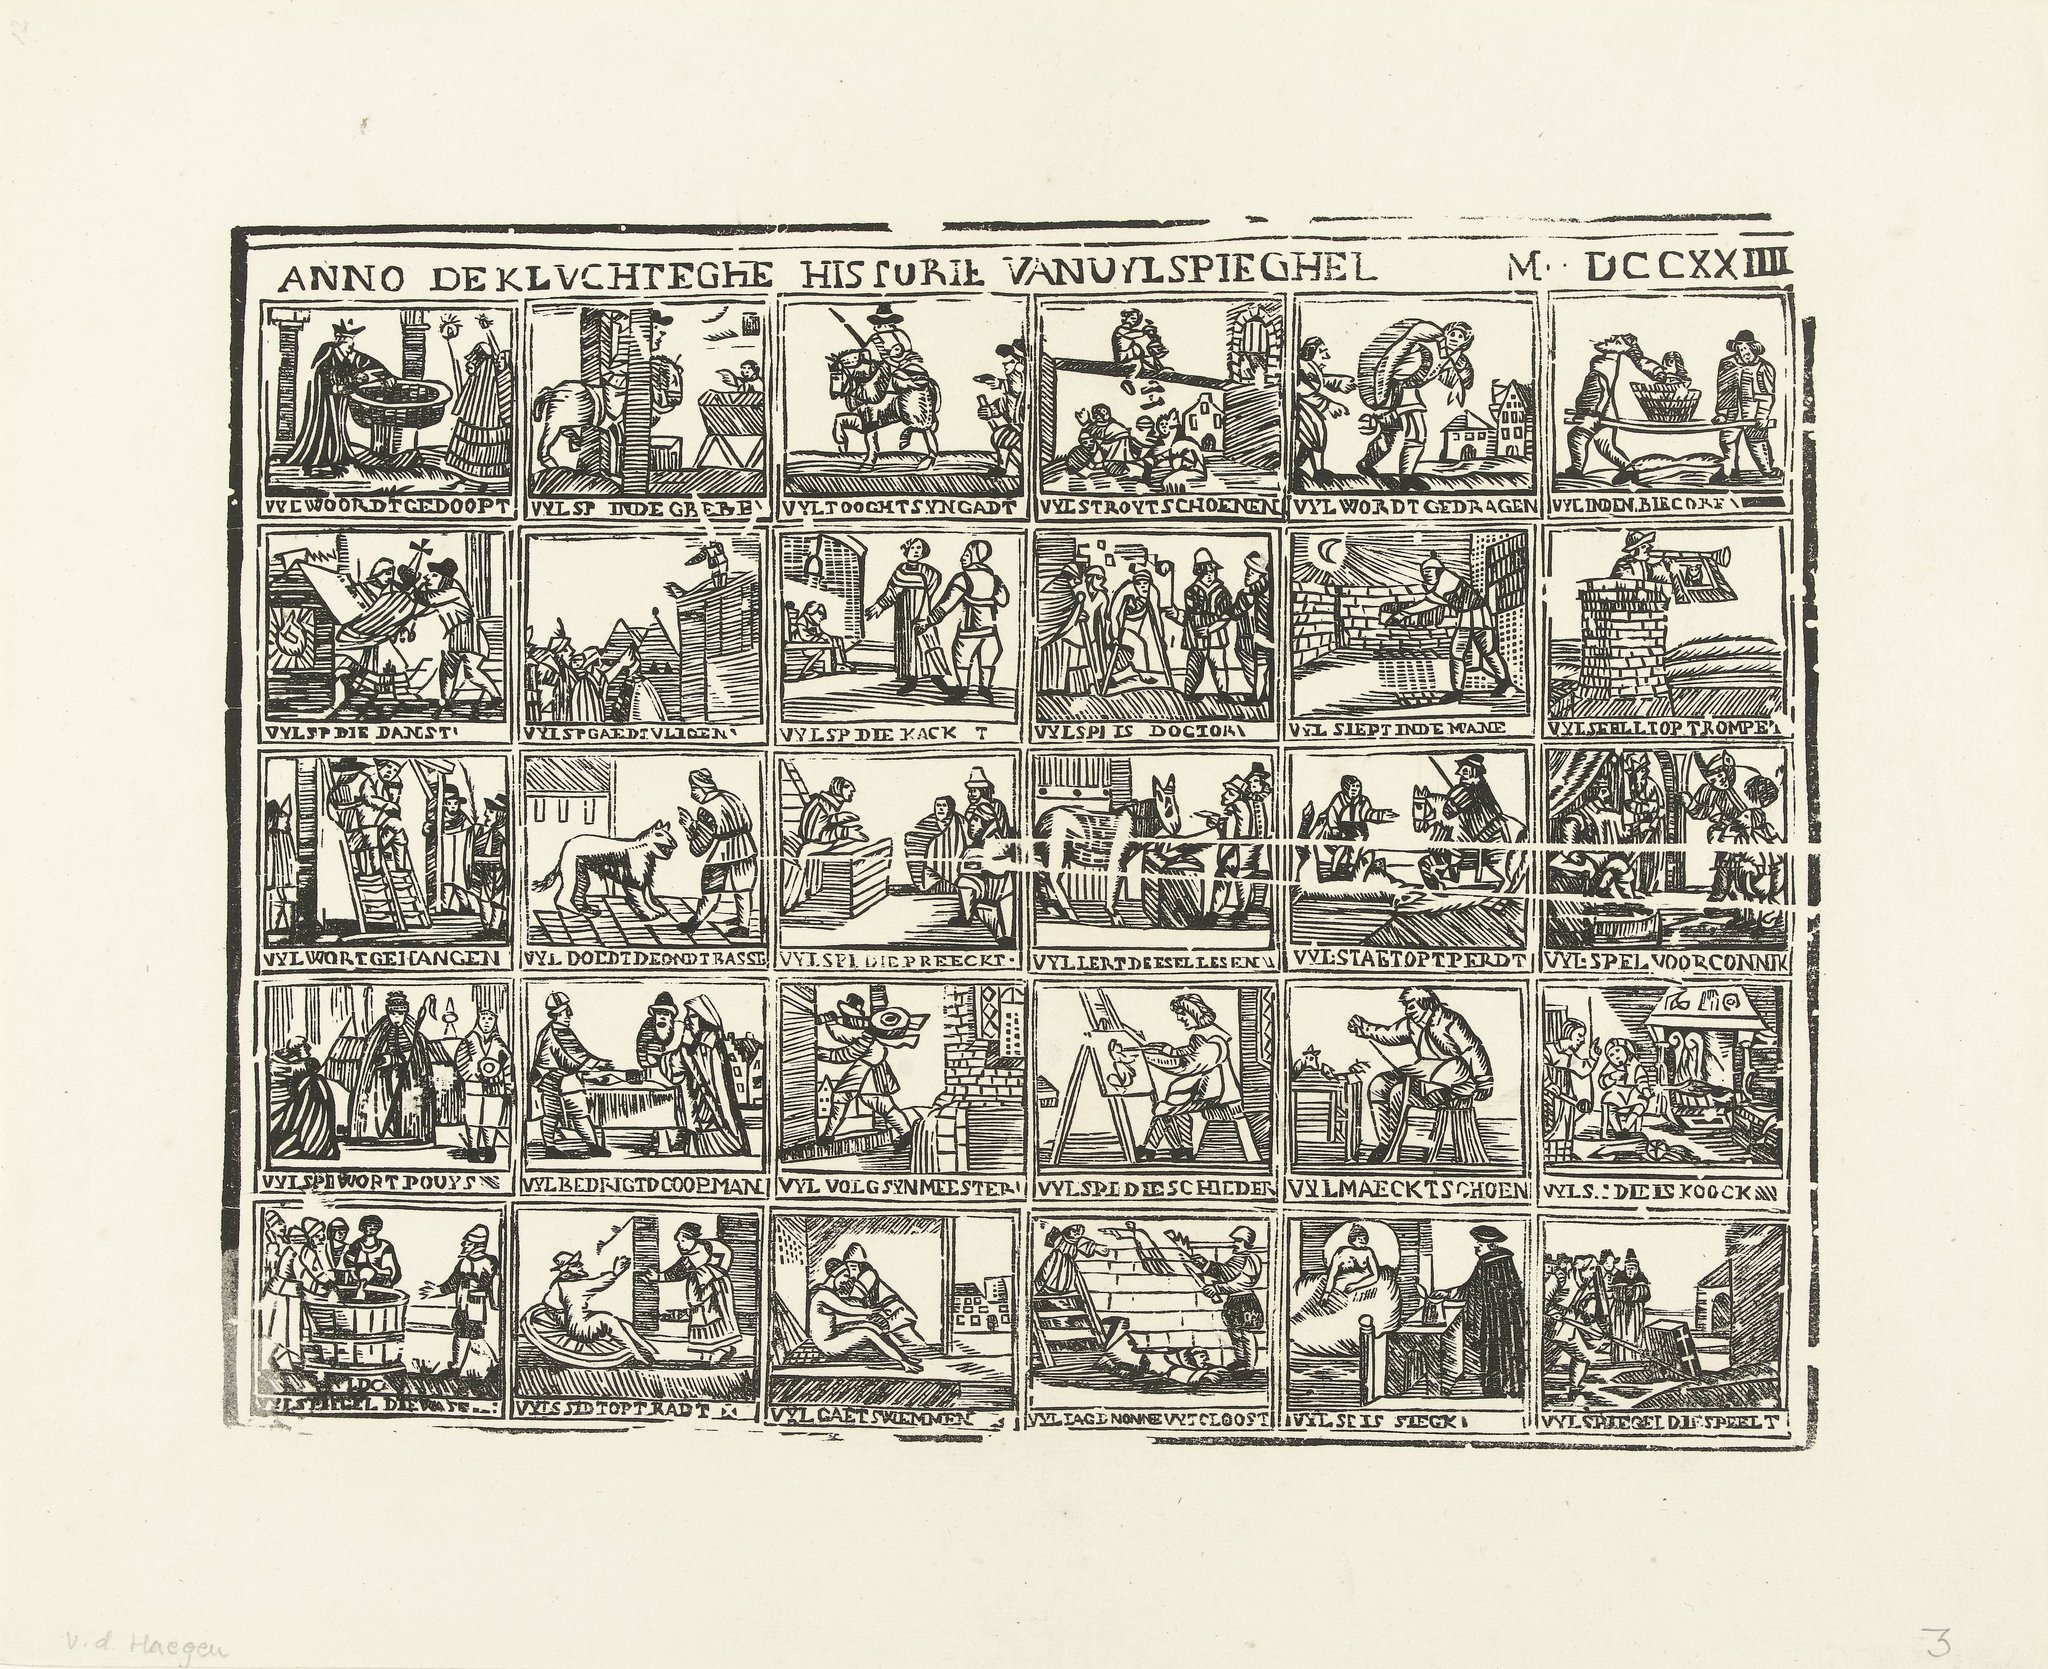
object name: popular print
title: De Klvchteghe Historie van Uylspieghel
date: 1724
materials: paper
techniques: woodcut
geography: ghent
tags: eulenspiegel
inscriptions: collector's mark: Lugt 2760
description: Blad met 30 voorstellingen over leven van Tijl Uilenspeigel. Onder elk plaatje een onderschrift.